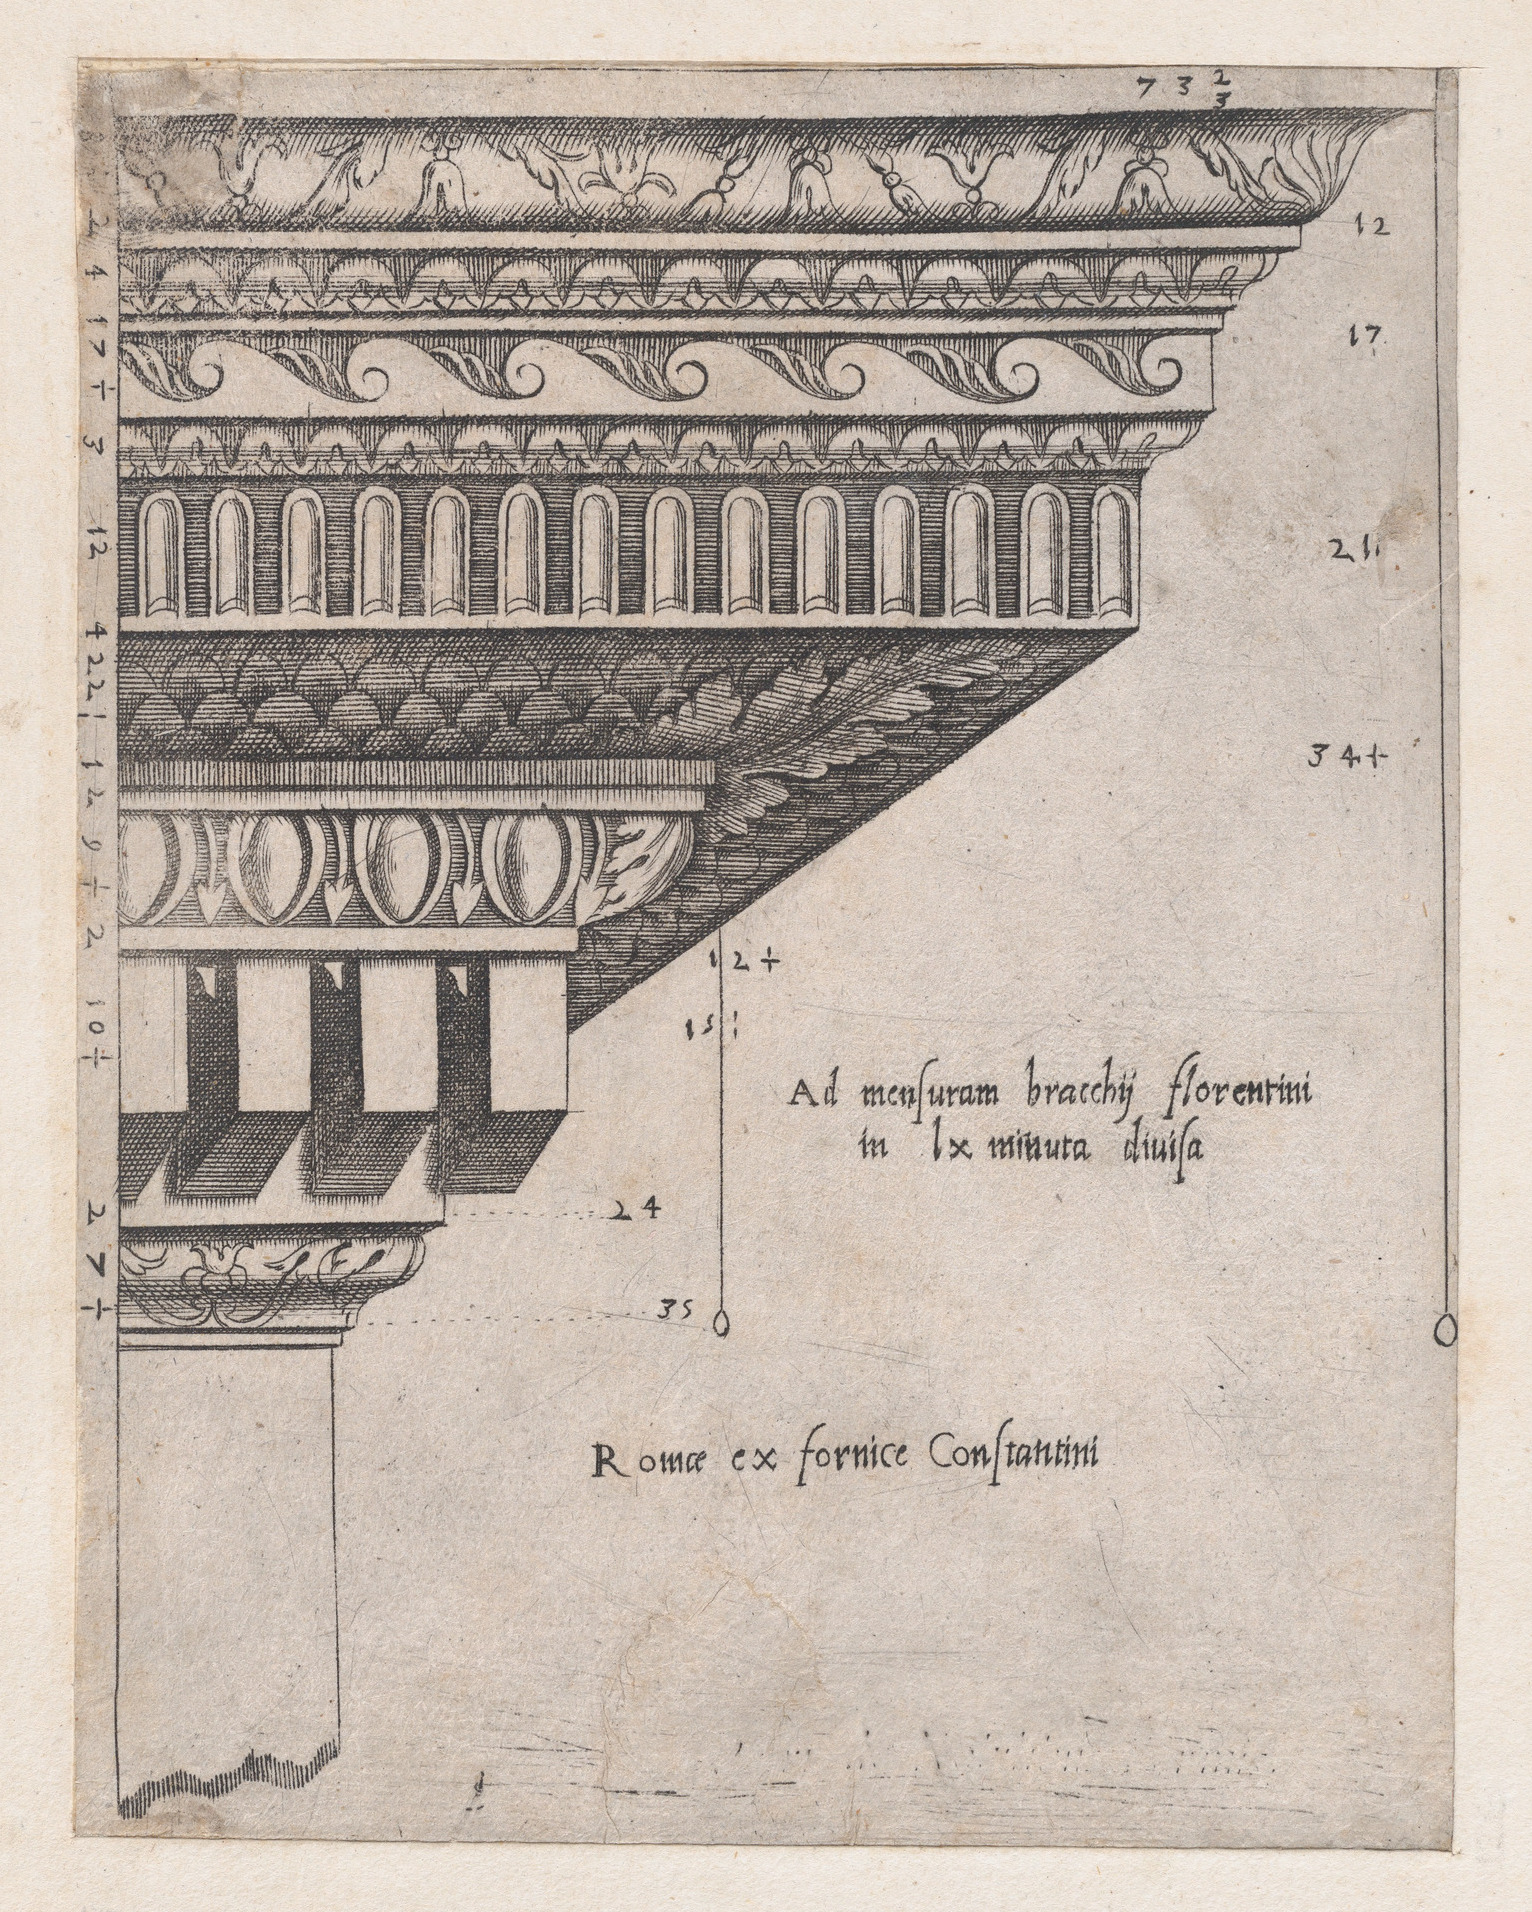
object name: print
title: Cornice, from "Speculum Romanae Magnificentiae"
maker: Anonymous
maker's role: artist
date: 1501-1600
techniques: engraving